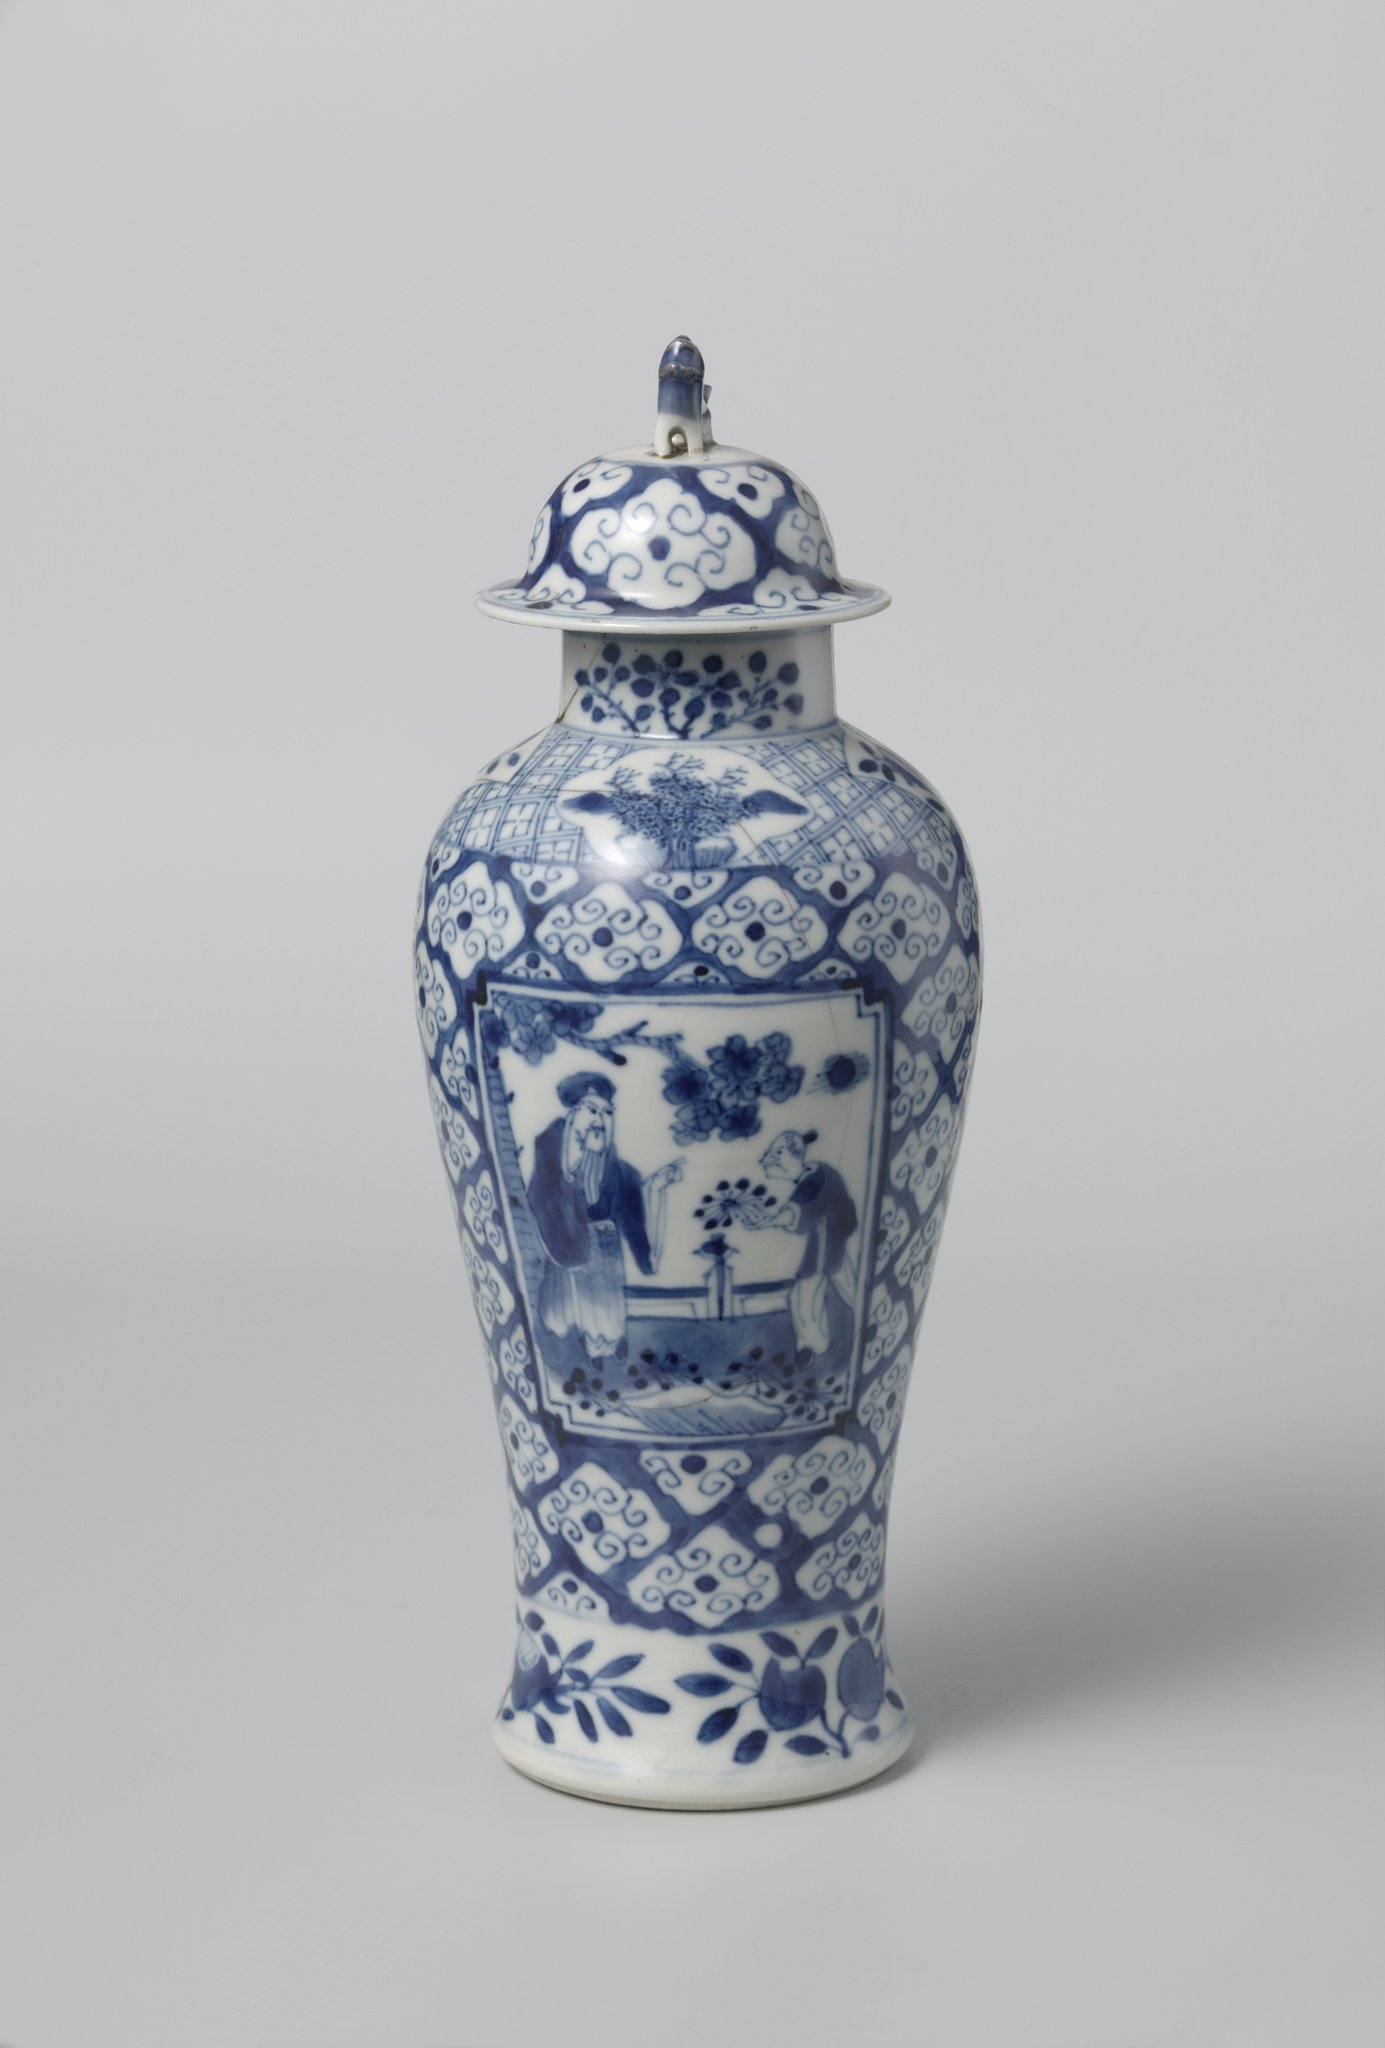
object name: lid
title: Baluster covered jar with figures in panels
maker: Anonymous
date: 1875-1899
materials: cobalt, glaze, paint, porcelain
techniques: firing, turning, vitrification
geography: china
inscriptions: mark: ‘康 熙 年 製’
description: Dekselknop in de vorm van een leeuw van balustervormige dekselpot van porselein, beschilderd in onderglazuur blauw. Bedekt met een geometrisch patroon waarin twee cartouches met twee personen in een omheinde tuin zijn afgebeeld. Deel missend uit de rand van de deksel. Blauw-wit.